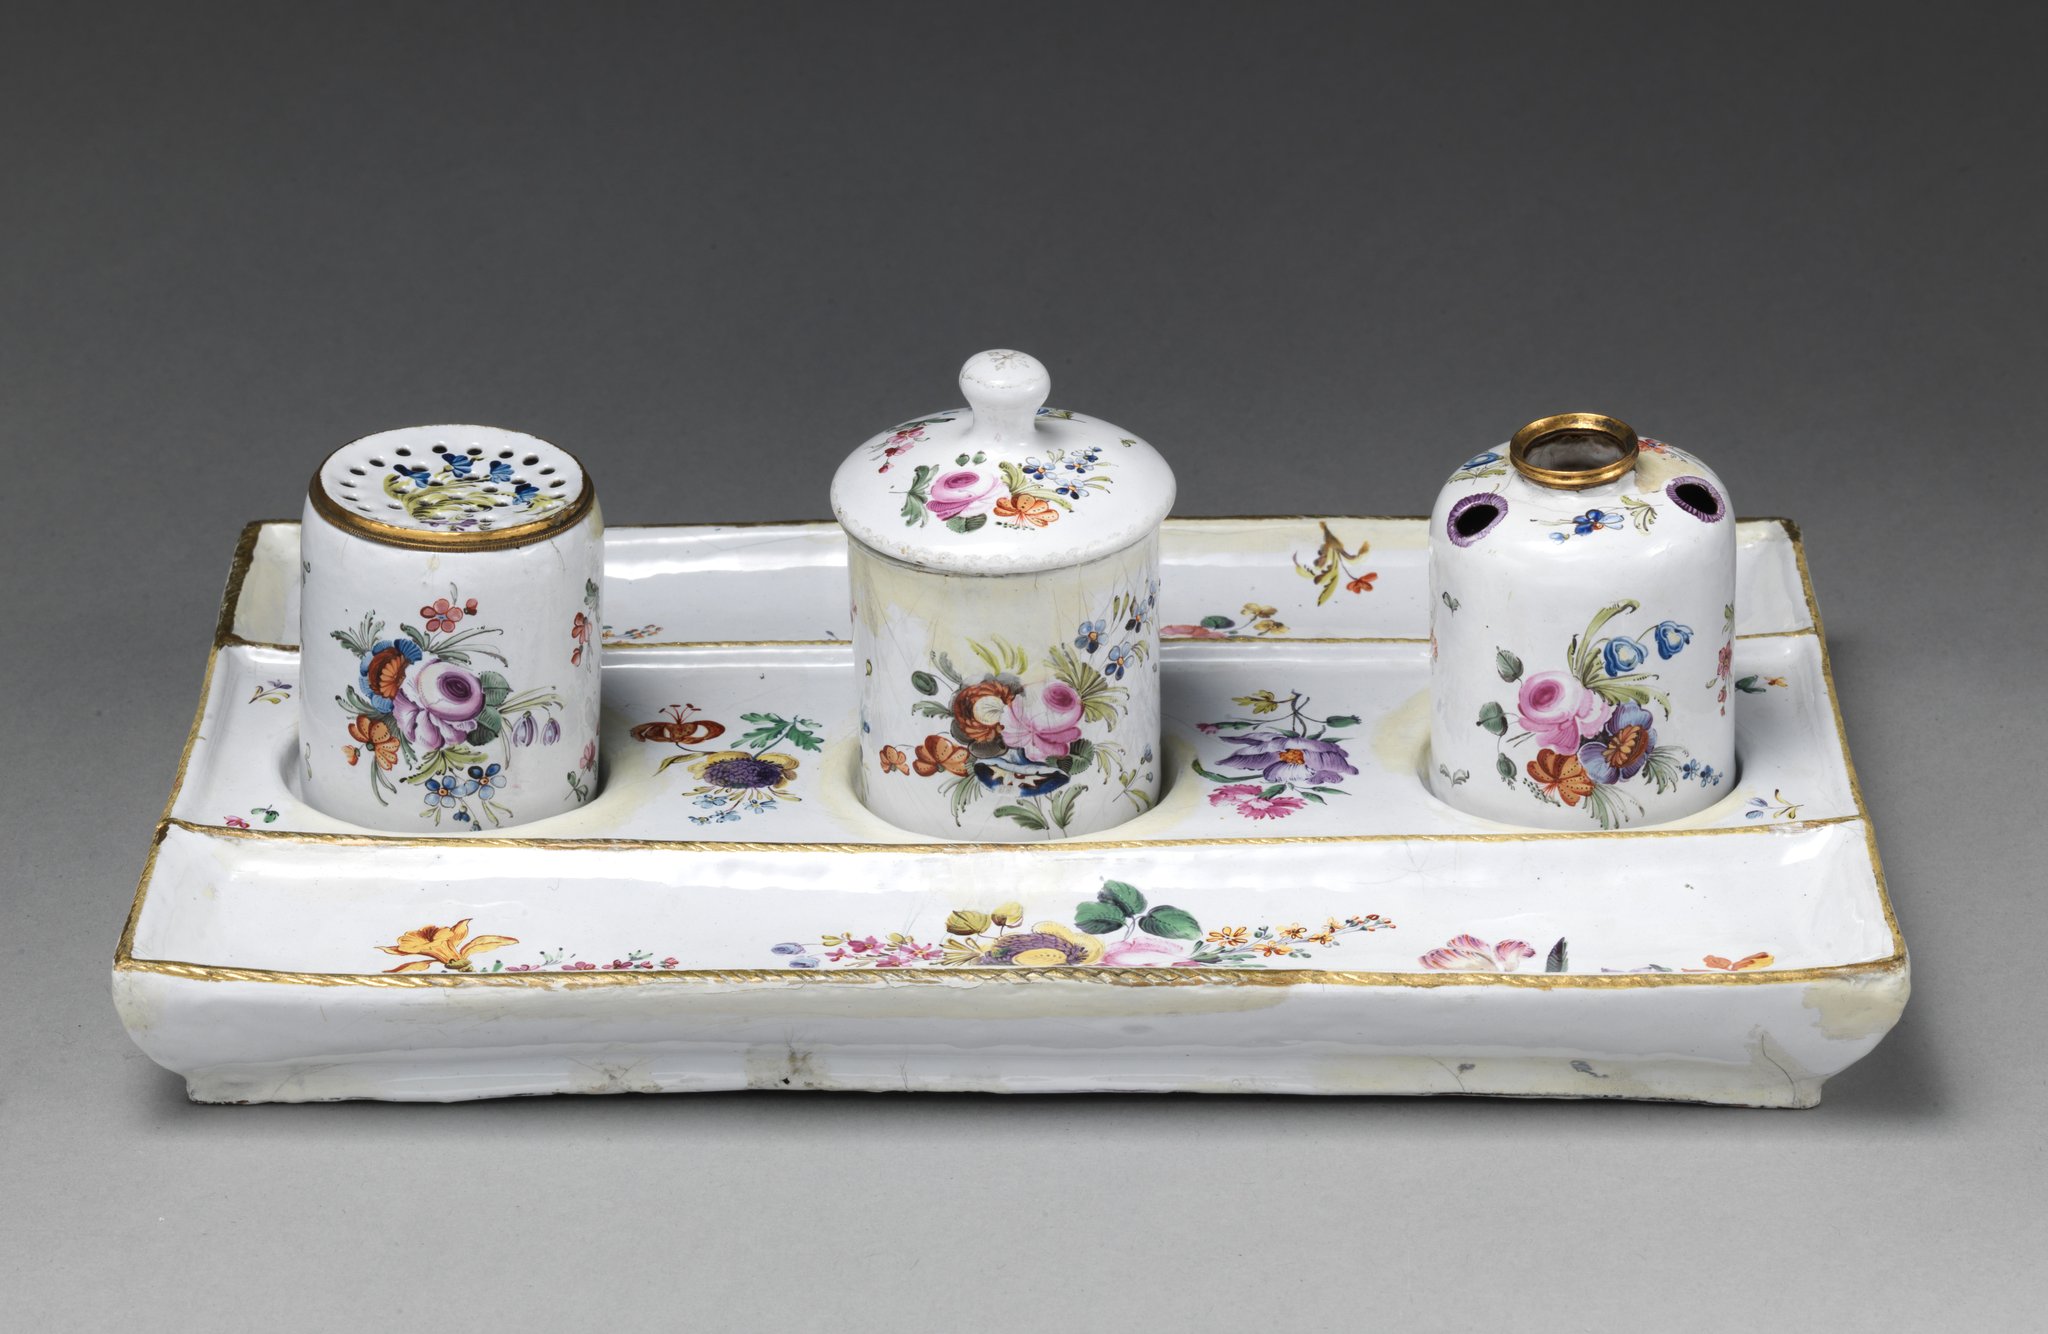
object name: standish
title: Standish with pounce pot, wafer box, and inkwell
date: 1765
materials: copper, enamel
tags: flowers